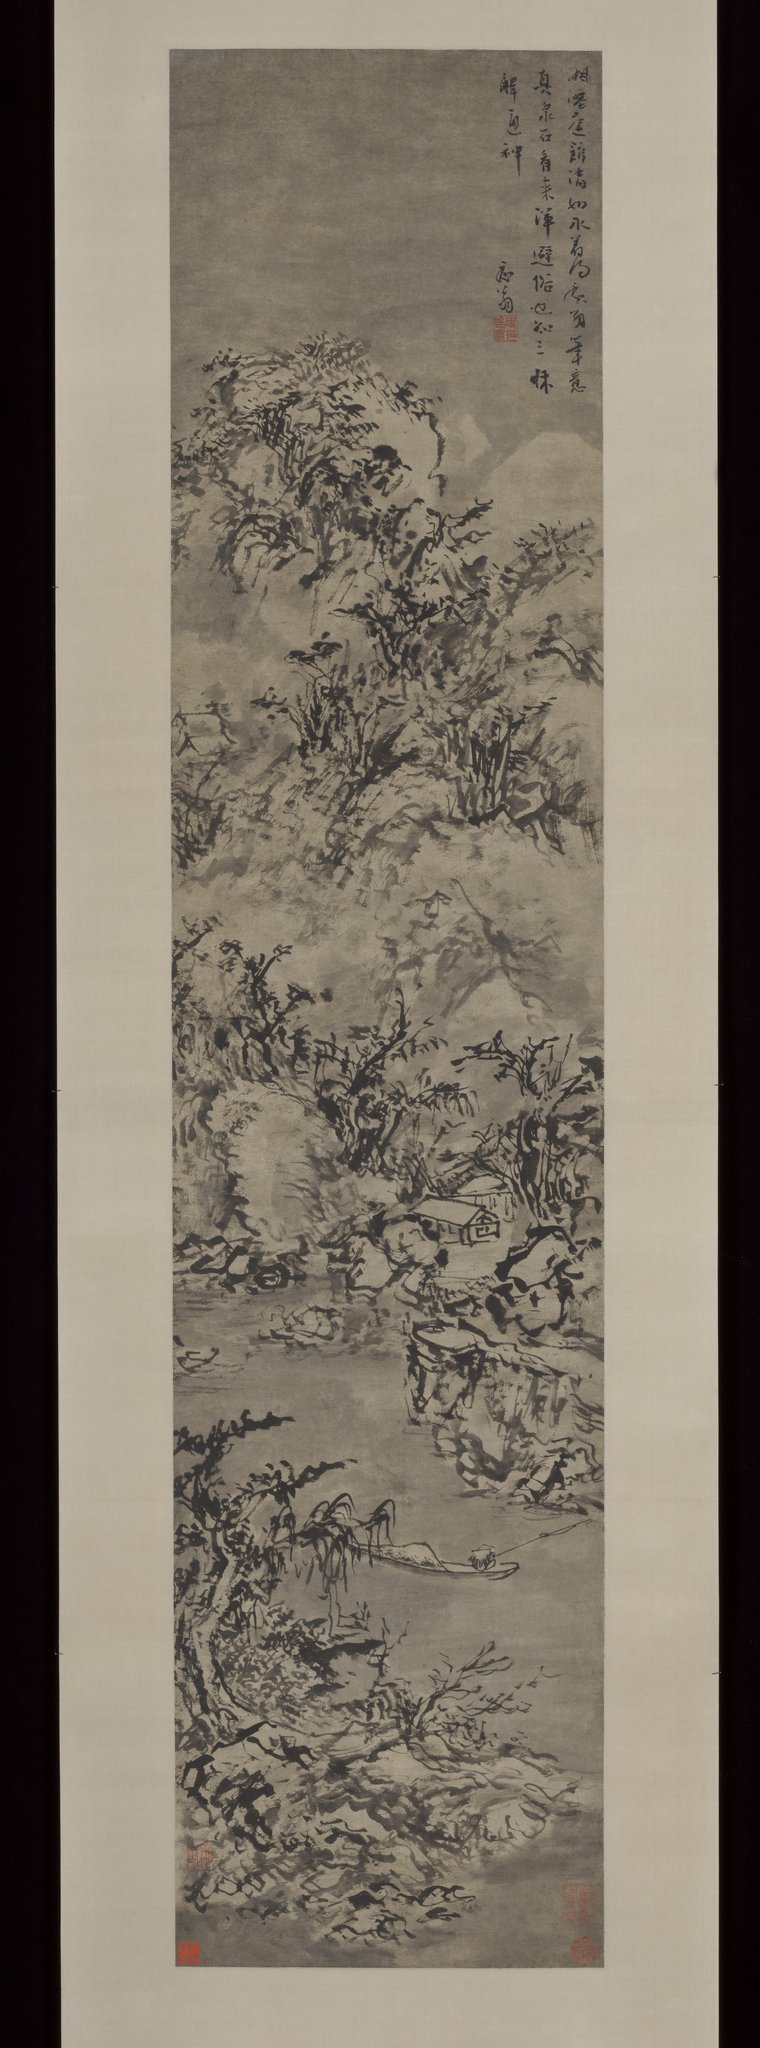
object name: hanging scroll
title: Winter landscape with fisherman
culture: chinese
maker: shi zhong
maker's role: artist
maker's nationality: chinese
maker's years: 1438-1506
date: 1467-1533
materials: ink, paper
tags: fishing,landscapes,boats